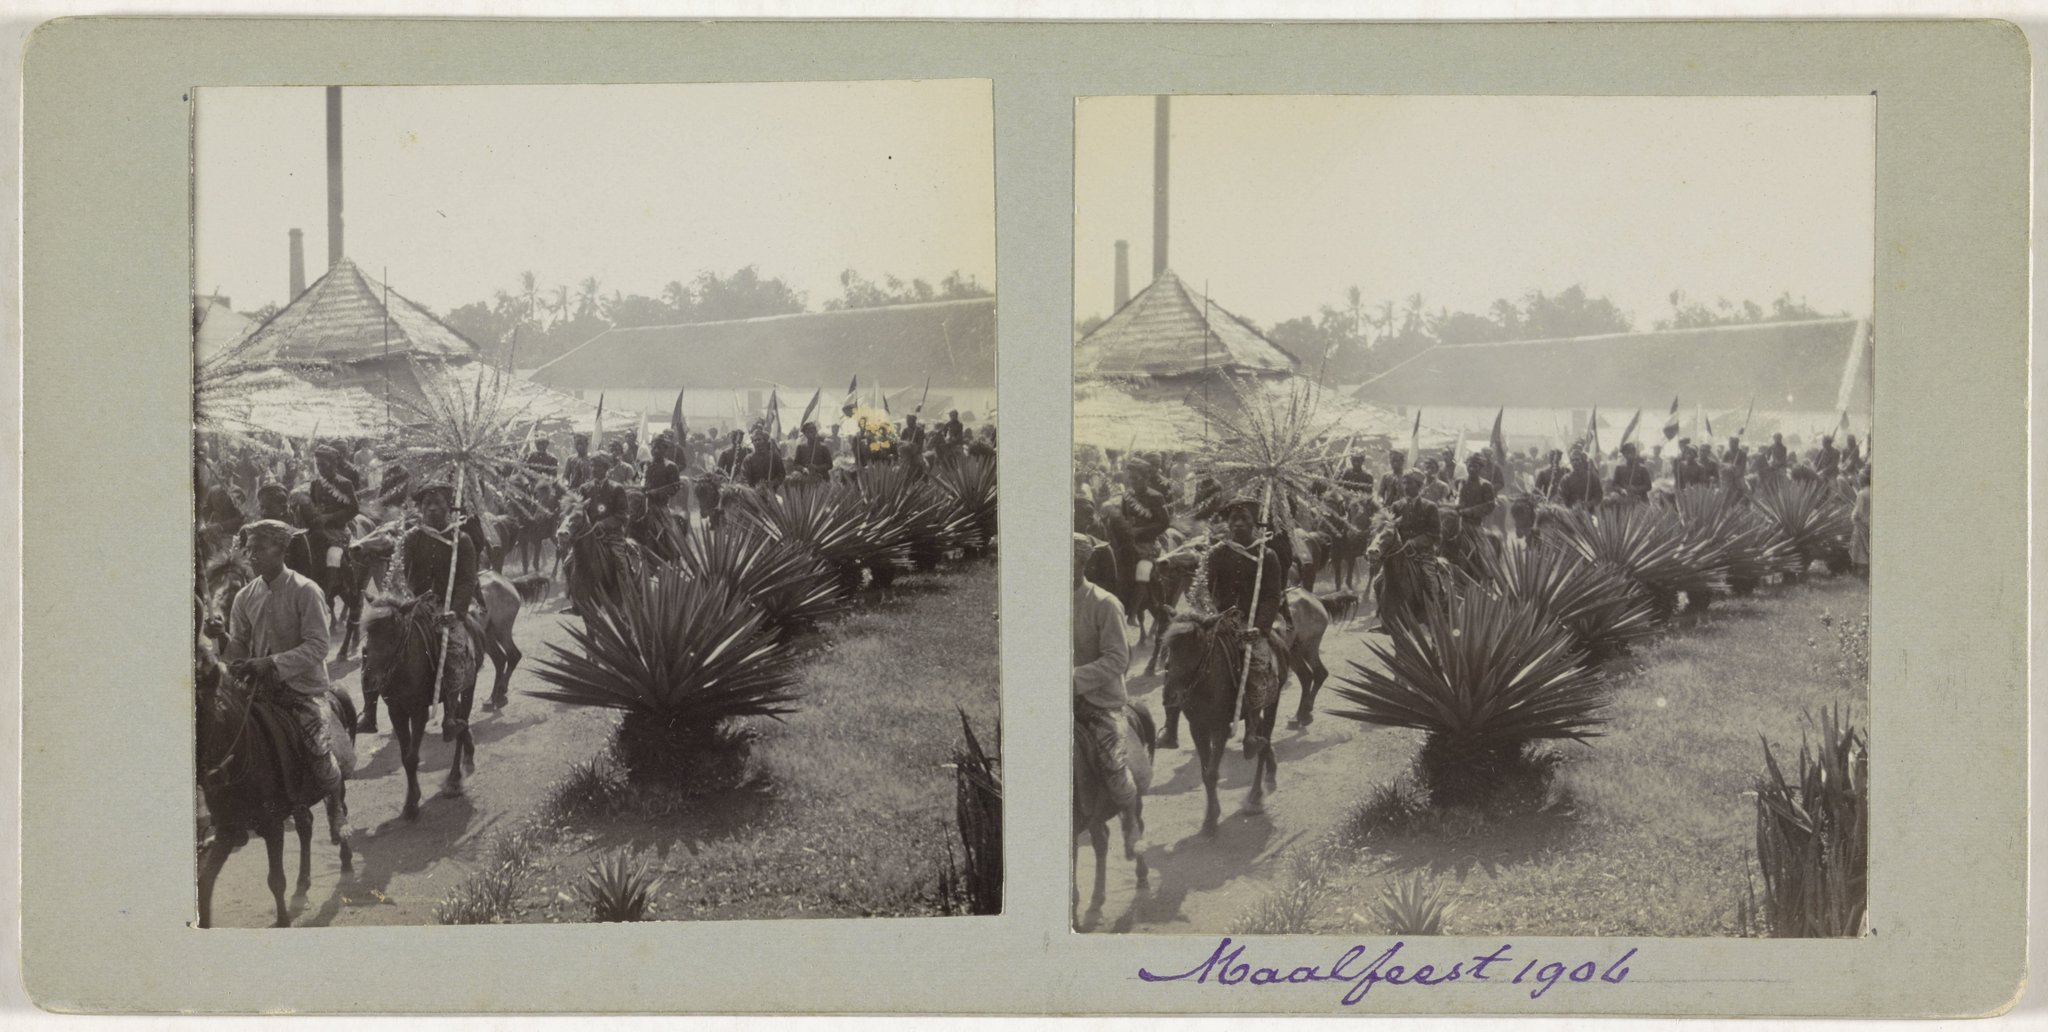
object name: stereograph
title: Optocht van mannen rijdend op paarden tijdens het Maalfeest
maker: Anonymous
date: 1906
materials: cardboard, paper, photographic support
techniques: albumen print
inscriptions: title: ‘Maalfeest 1906’